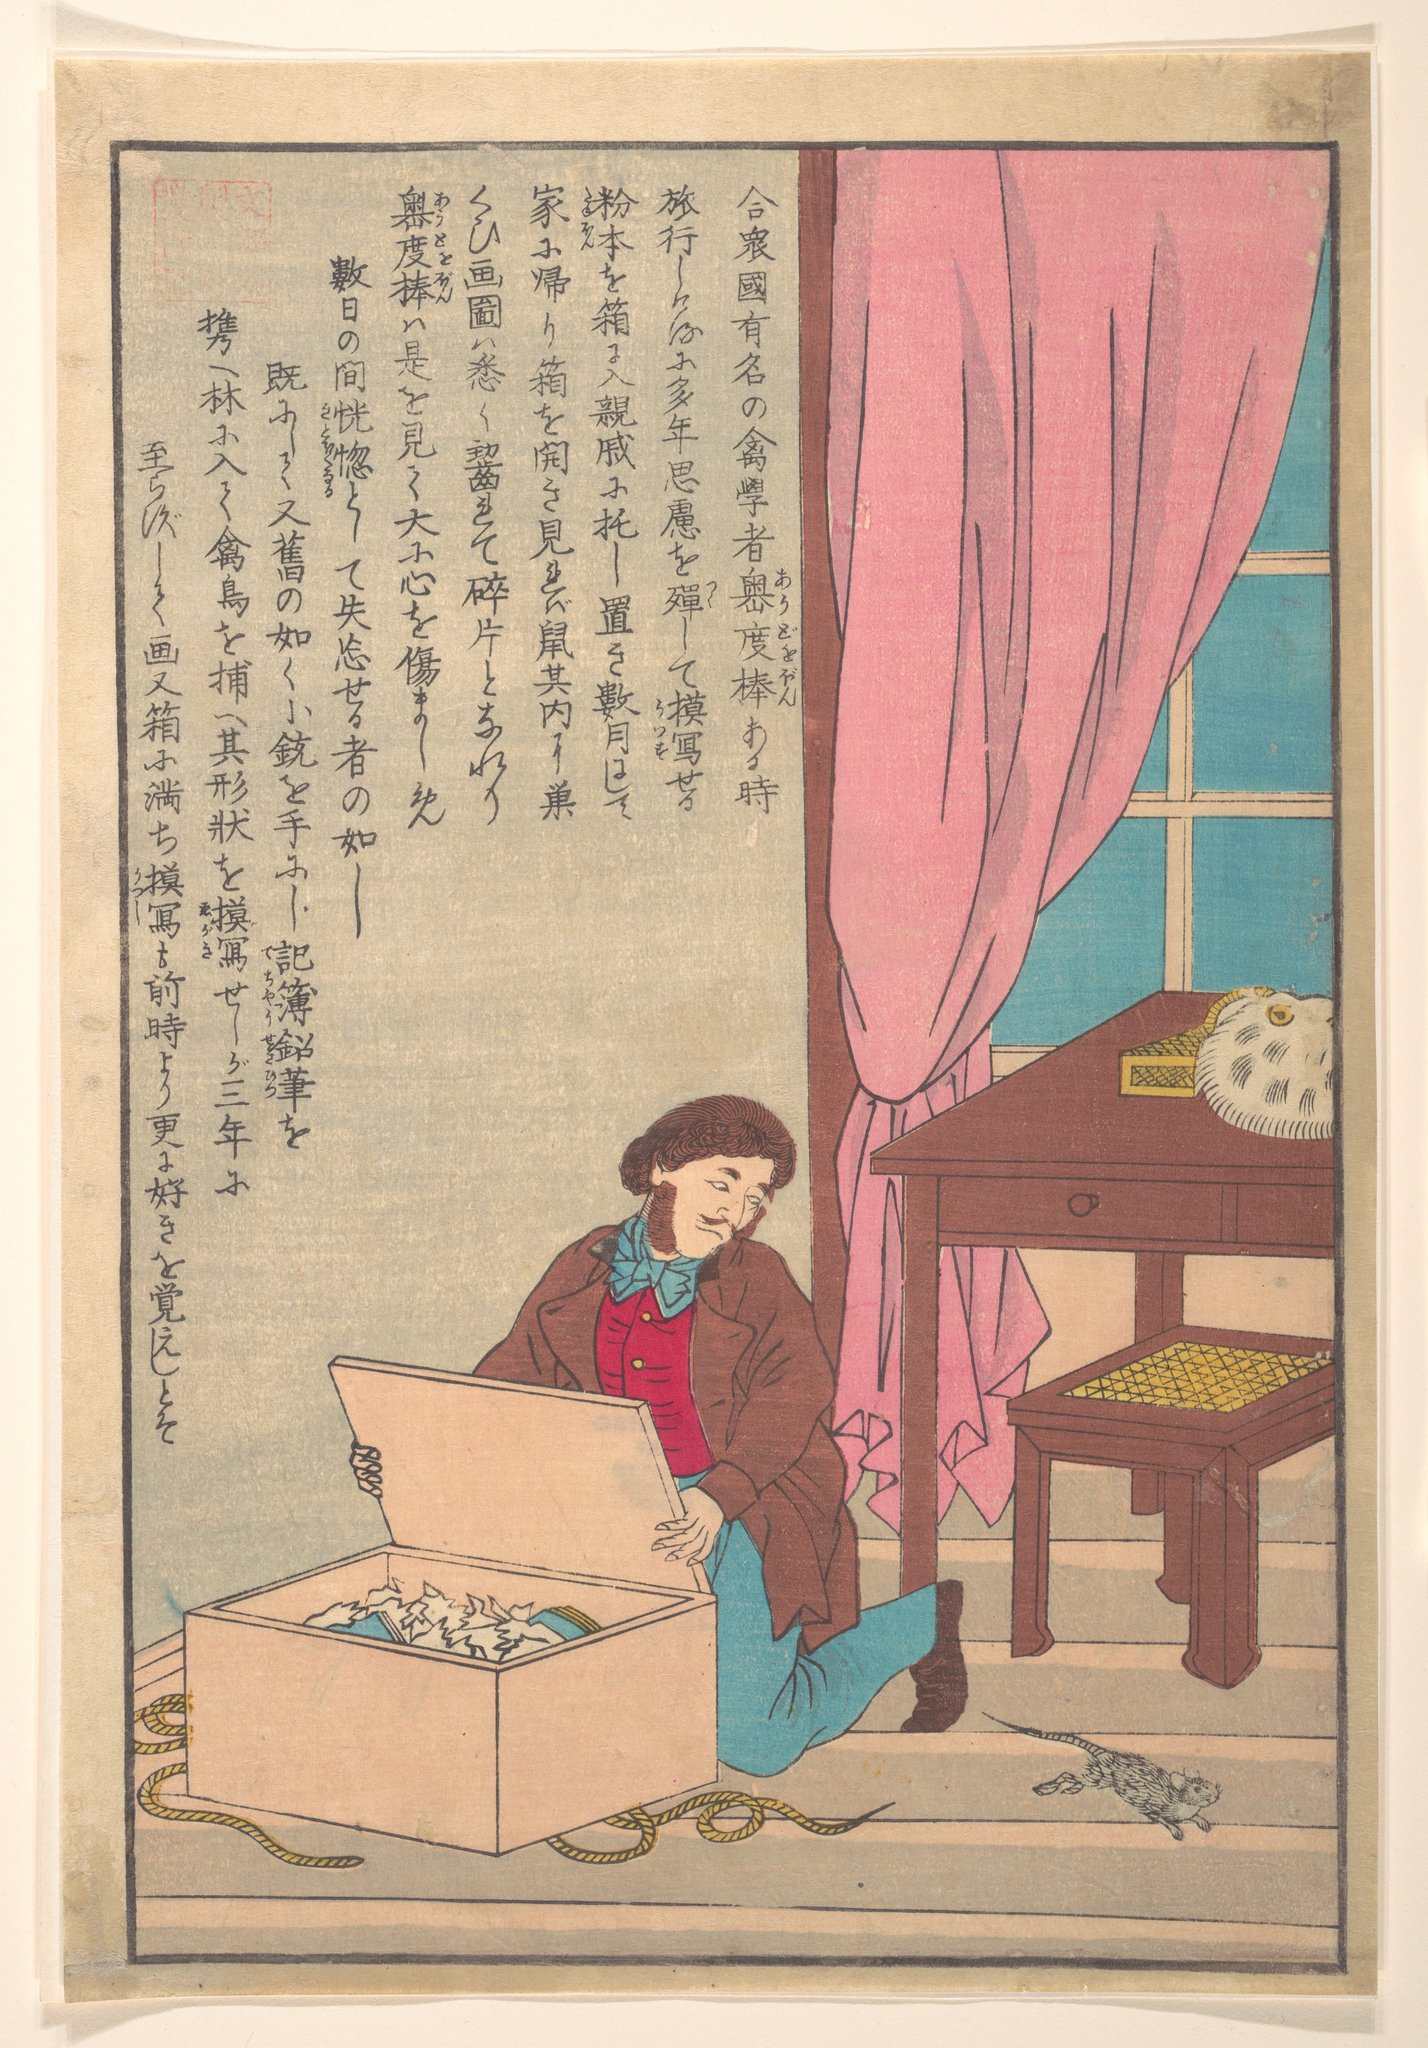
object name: print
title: Lives of Great People of the Occident (Taisei ijin den): John James Audobon, (1785-1851)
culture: japanese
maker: unidentified artist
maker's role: artist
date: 1870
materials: ink, paper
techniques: woodblock print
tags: men,mice,chairs,tables